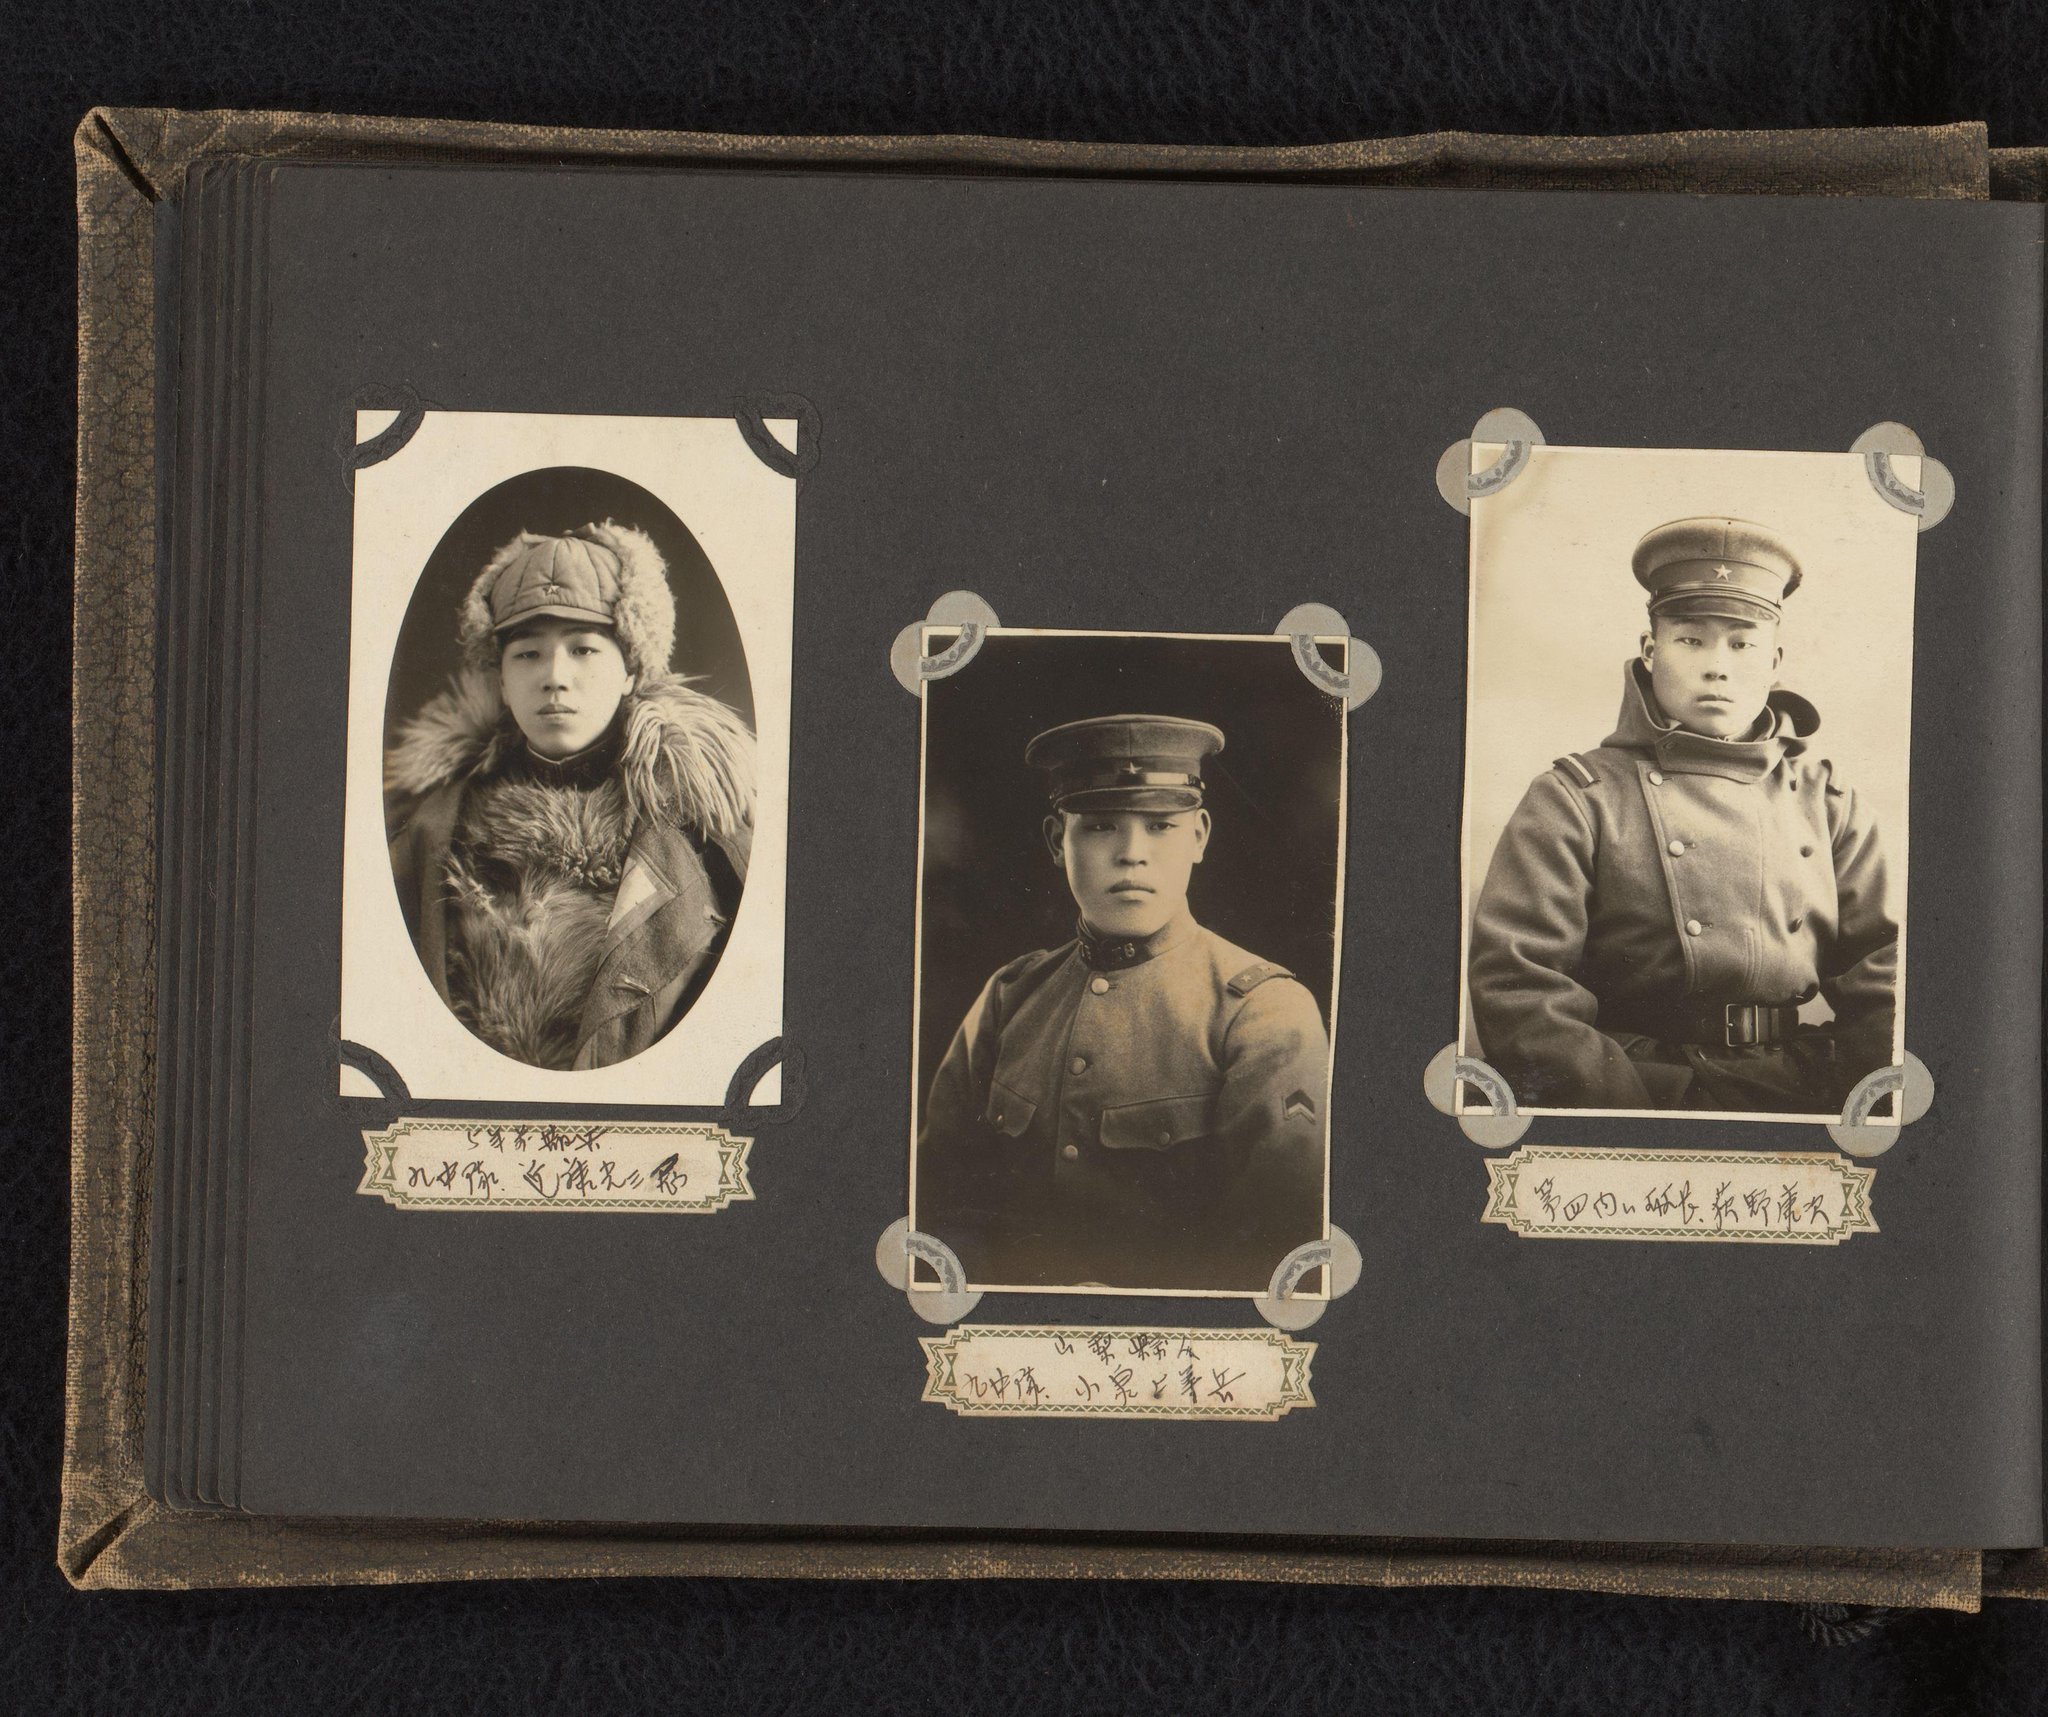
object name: photograph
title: Drie portretten van onbekende Japanse soldaten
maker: Anonymous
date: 1930-1940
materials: paper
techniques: gelatin silver print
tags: anonymous historical person portrayed, the soldier; the soldier's life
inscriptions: inscription: ‘[...]’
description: Deze foto's zijn onderdeel van een album.